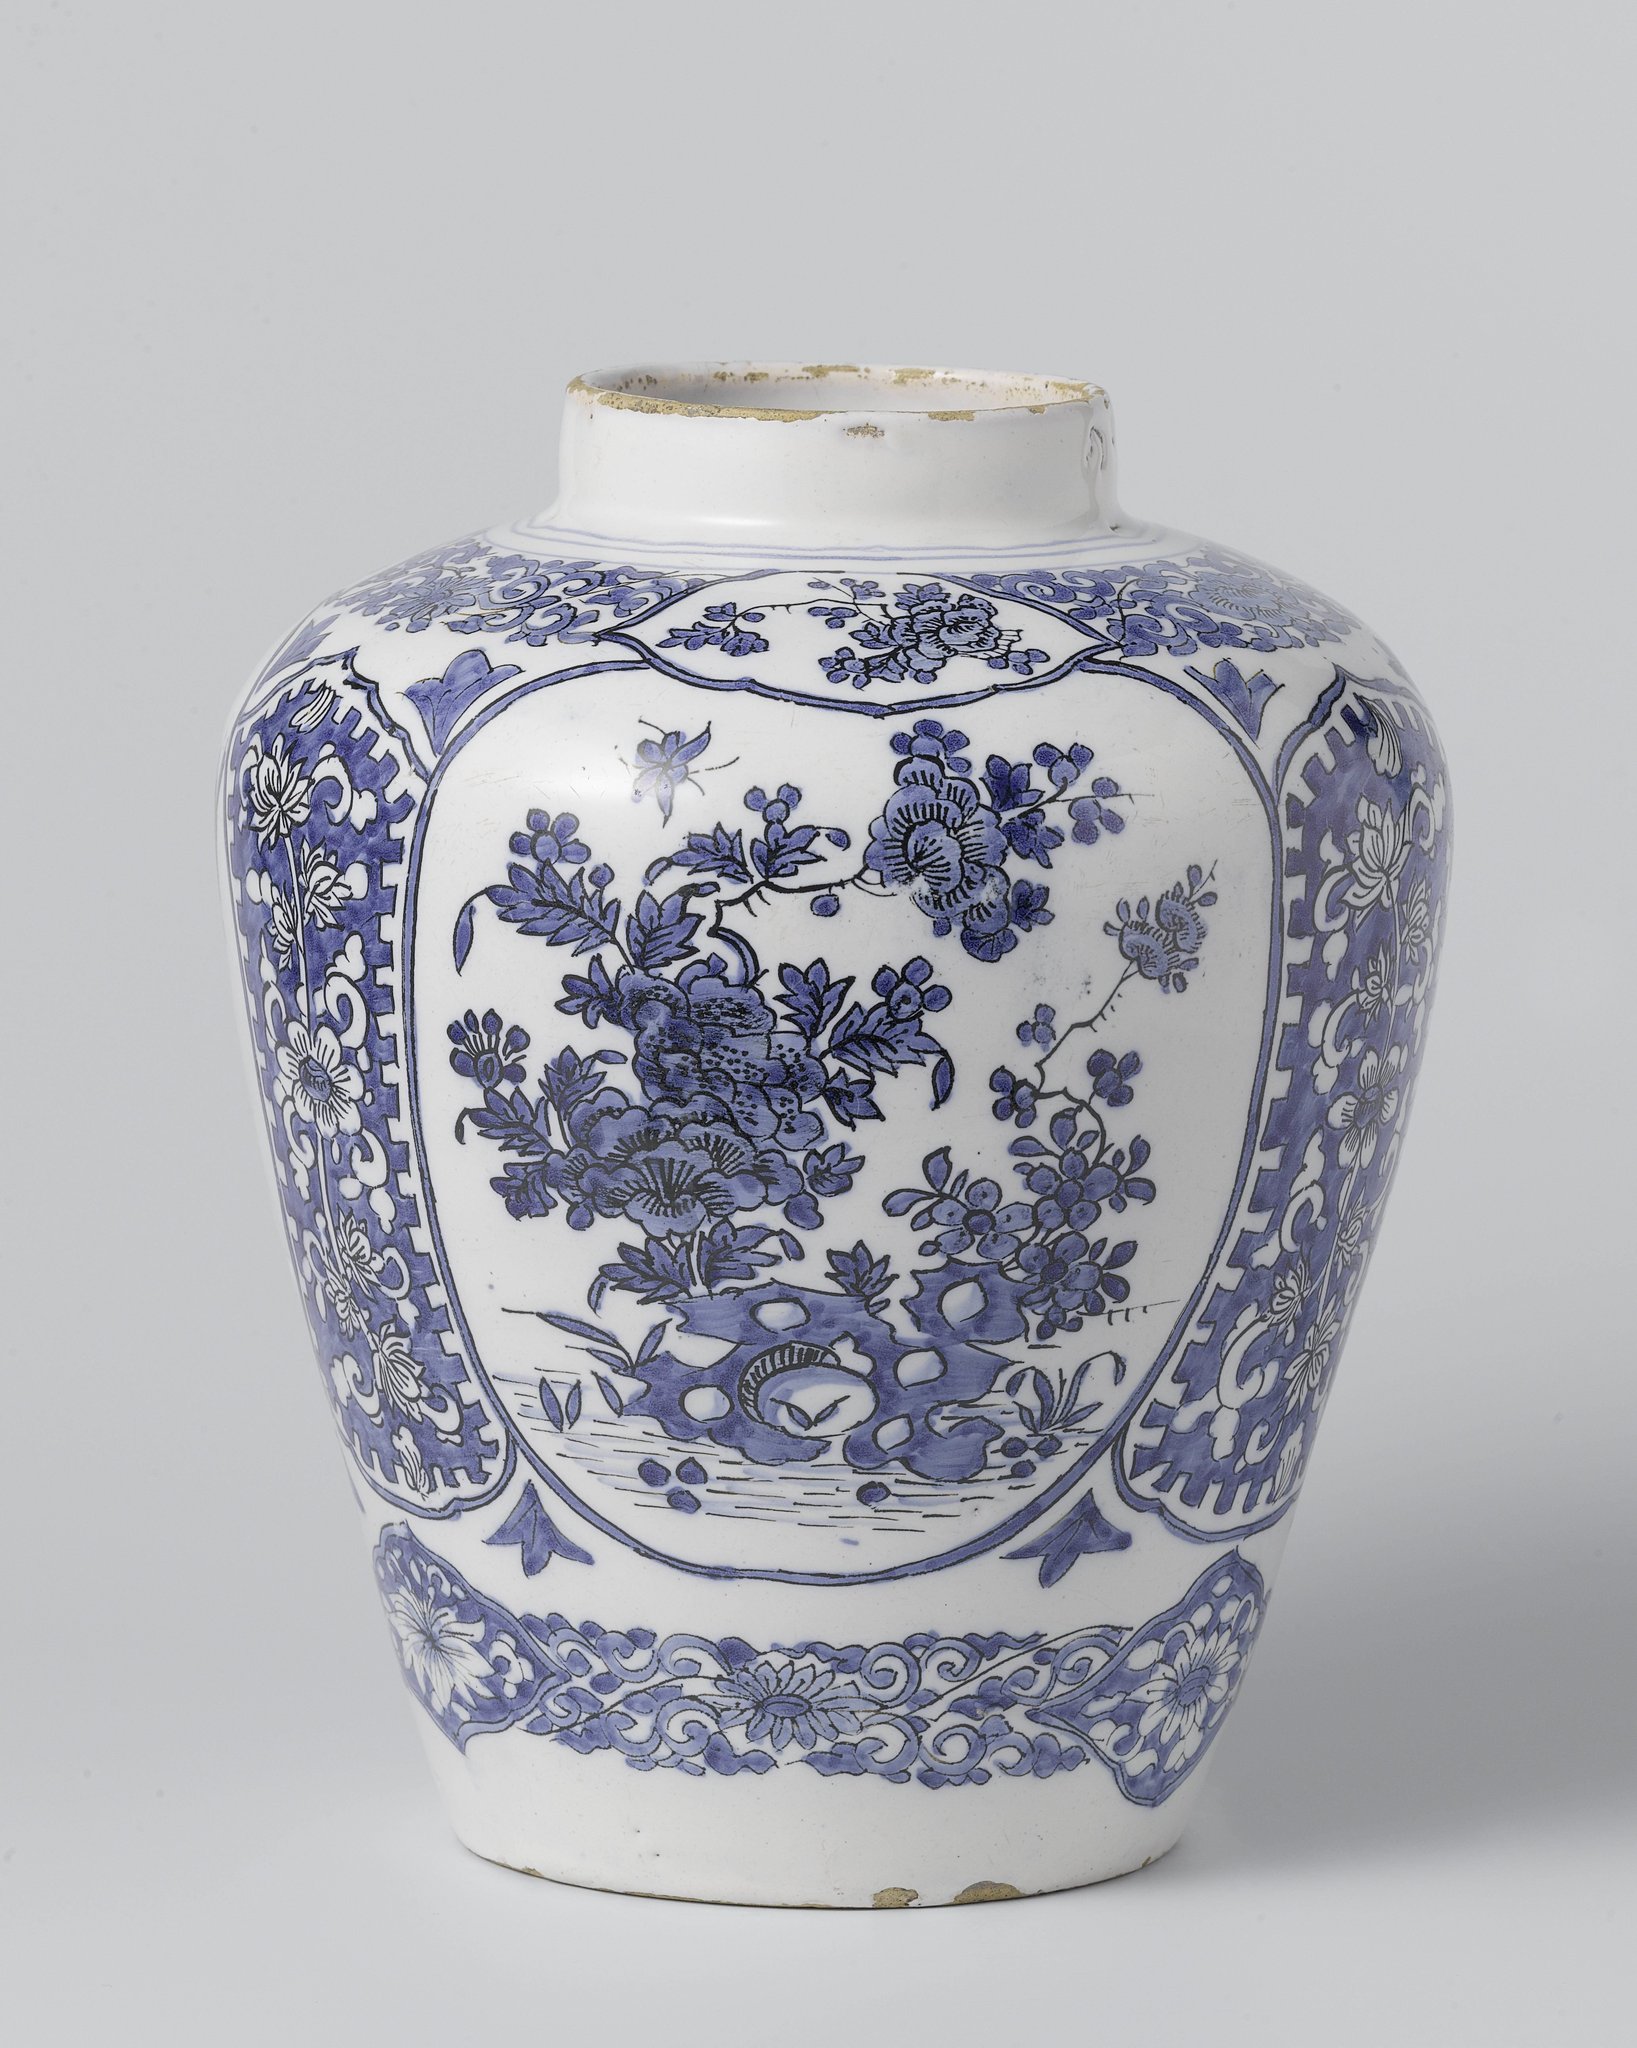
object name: covered jar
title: pot (zonder deksel) van faience met bloemdecoratie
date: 1670-1690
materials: faience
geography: delft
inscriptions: inscription: ‘343’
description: Pot (zonder deksel) van faience met een op het Chinese porselein geïnspireerde bloemendecoratie.